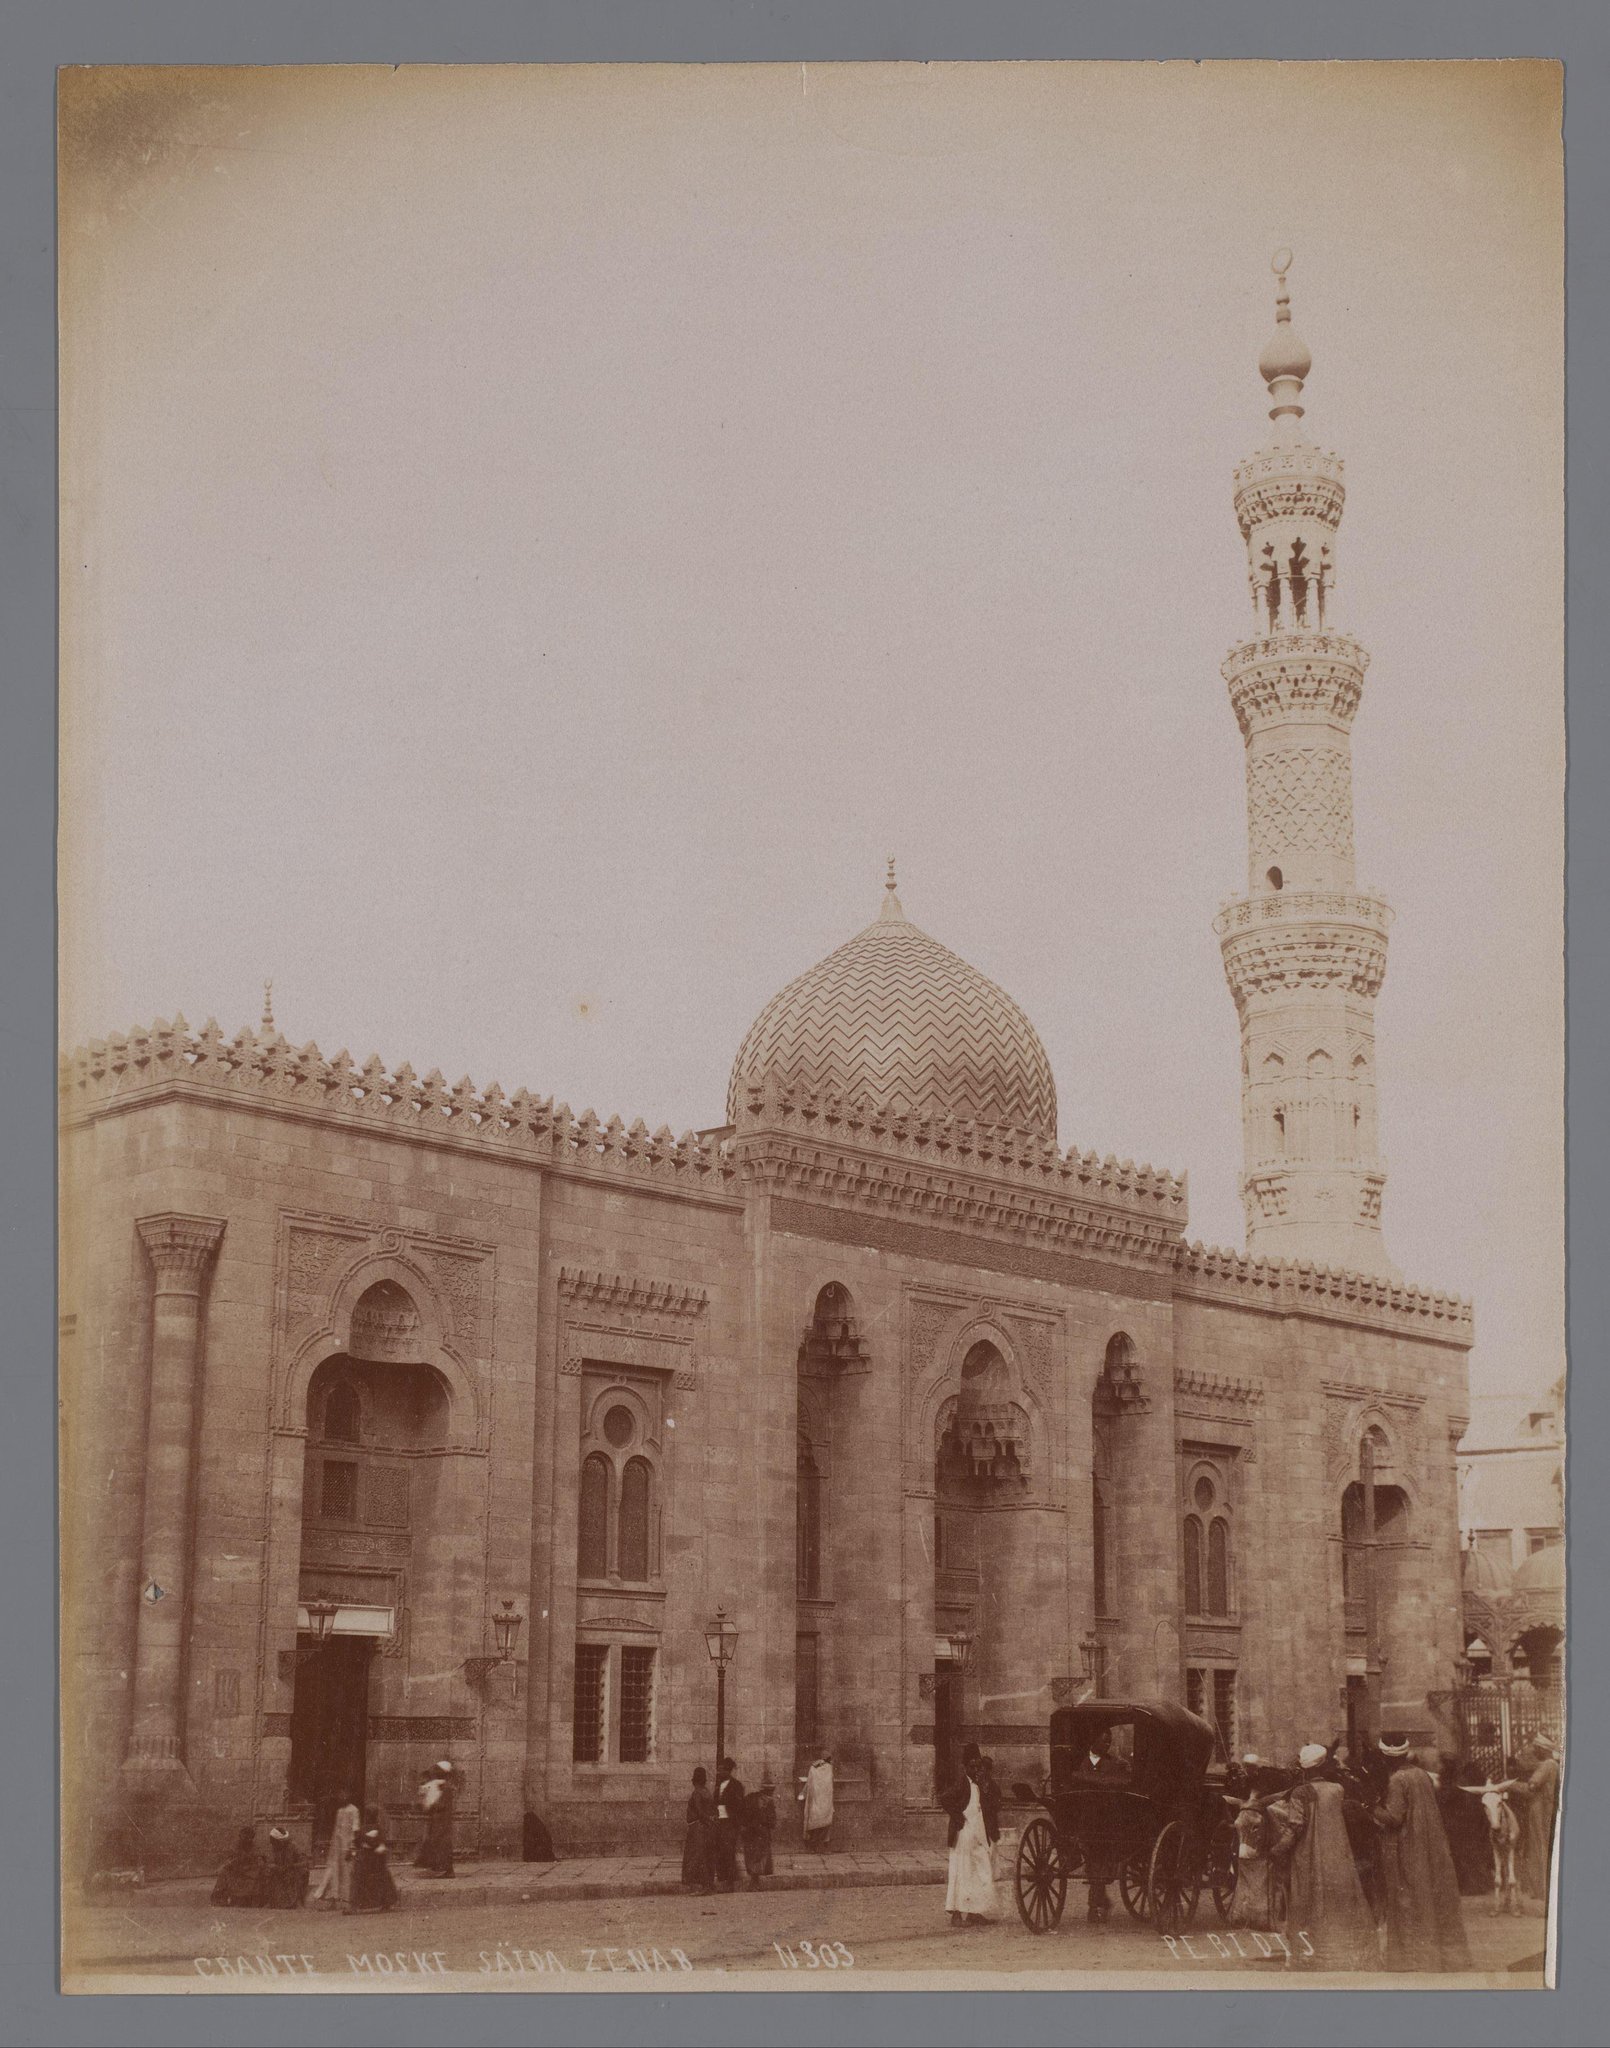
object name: photograph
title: Al-Sayeda Zainab moskee in Caïro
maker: peridis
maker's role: fotograaf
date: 1870-1900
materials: paper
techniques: albumen print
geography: cairo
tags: temple, shrine ~ islam, mohammedanism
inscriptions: number: ‘N 303’